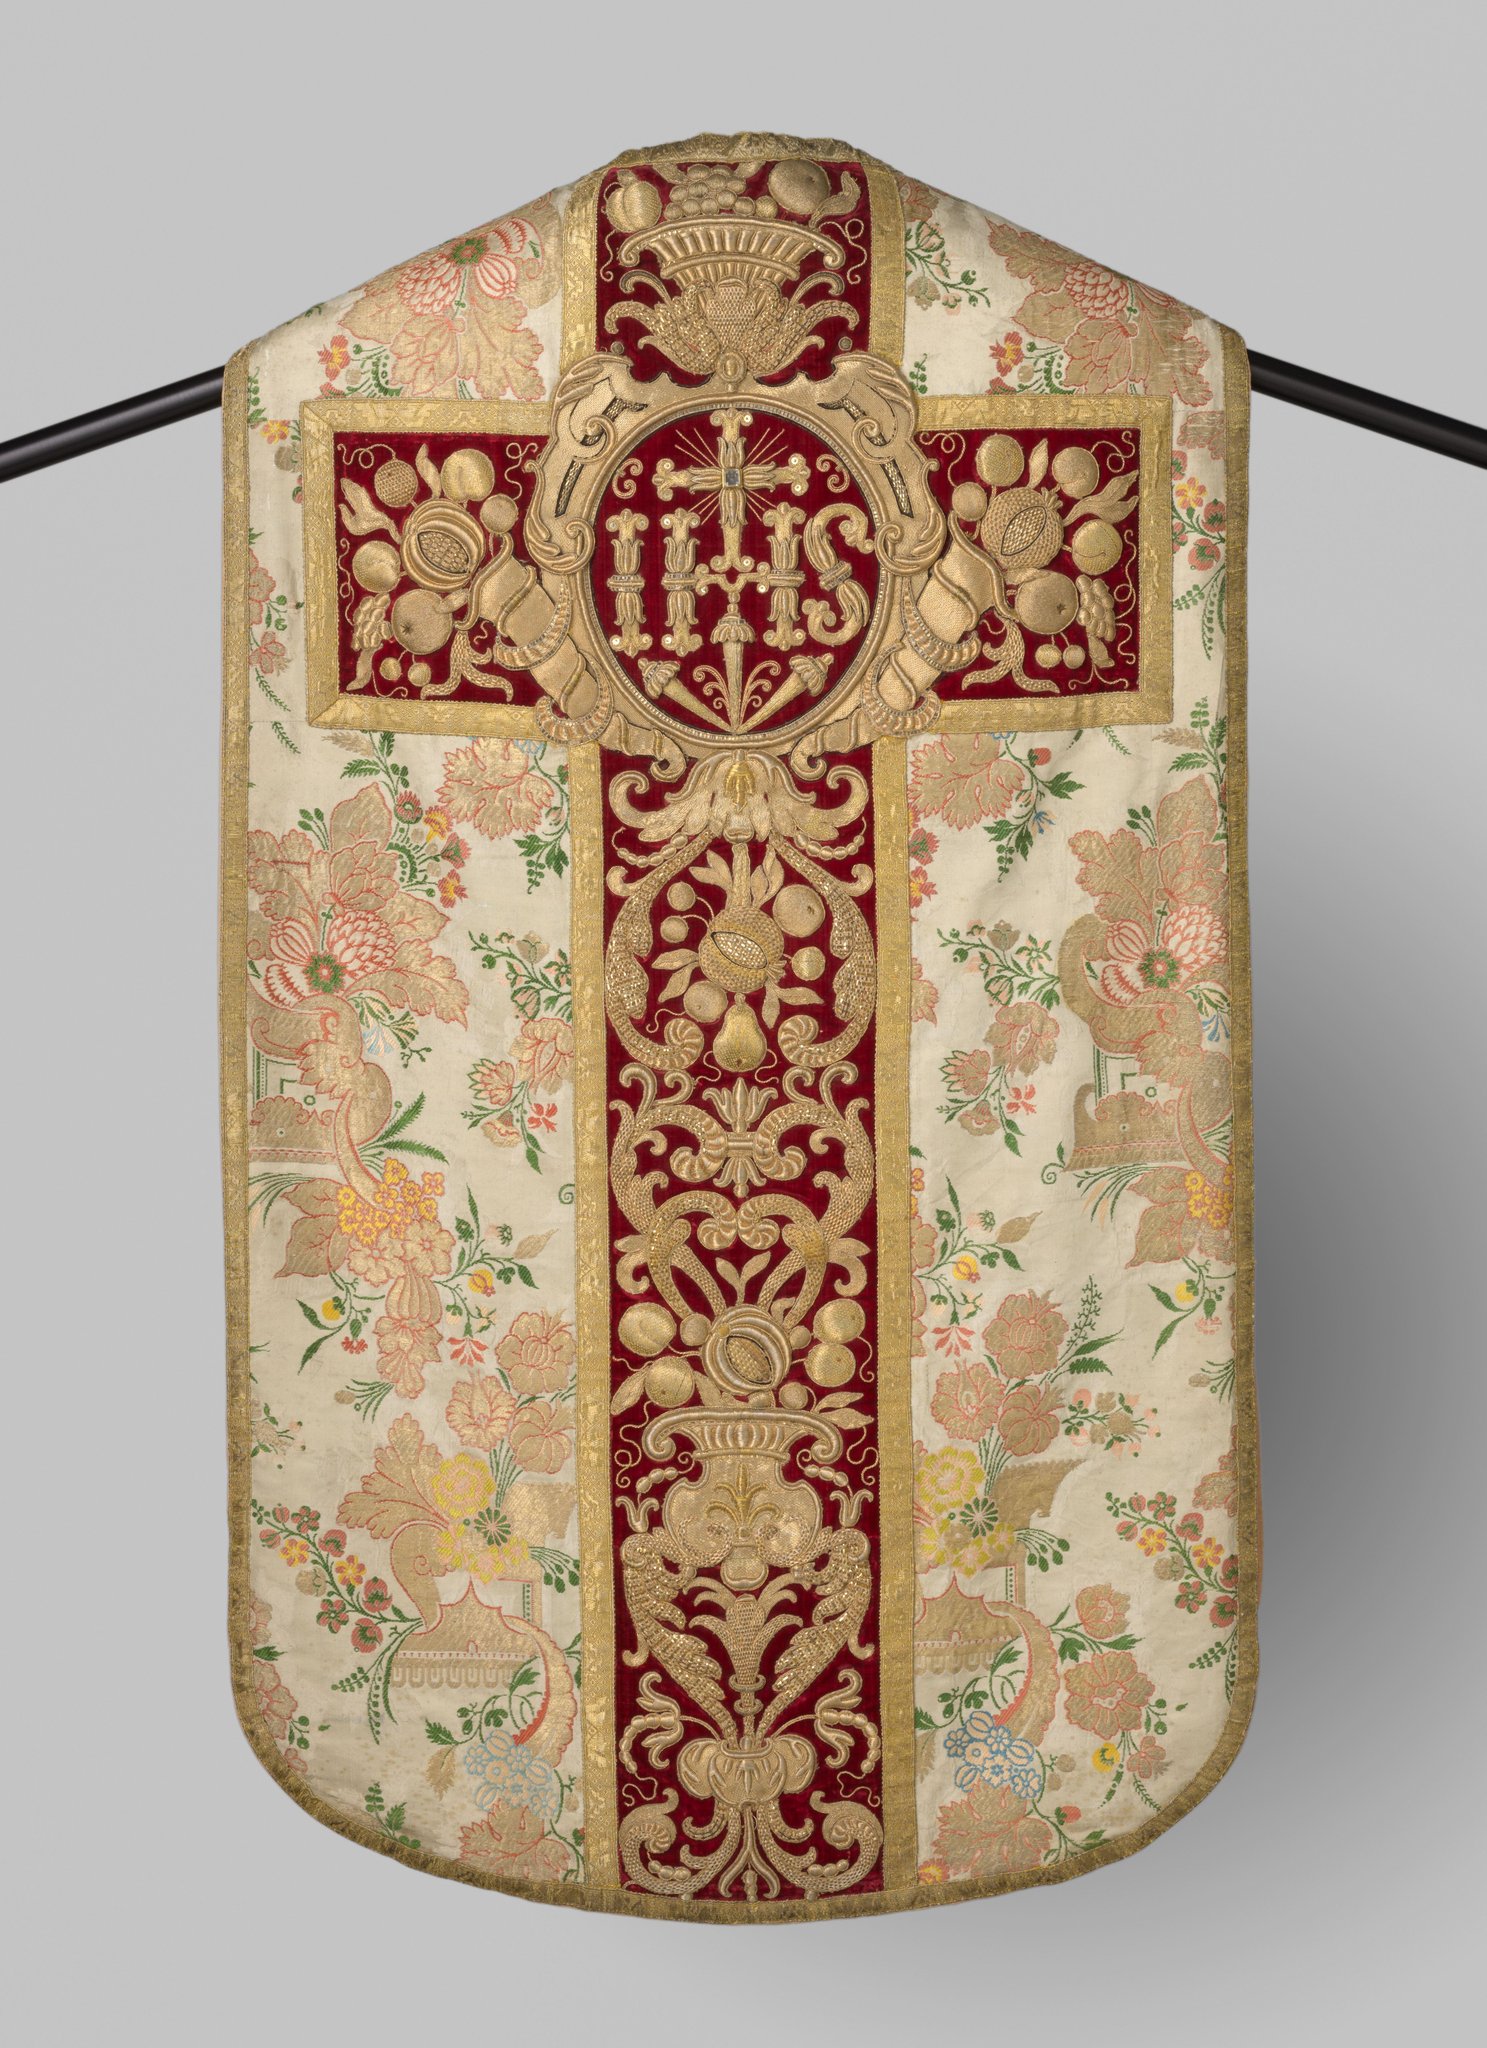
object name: chasuble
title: Kazuifel van goudbrokaat en borduurwerk in gouddraad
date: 1700-1725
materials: gold thread, velvet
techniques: brocade, embroidered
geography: france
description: Kazuifel met borduurwerk. De kazuifel heeft een vioolvorm met op de voorzijde een kolom en op de rug een kruisvormig aurifries. Op de kolom zijn symmetrische ranken geborduurd die een vaas dragen vanwaar dubbele voluten opgaan. Het rugkruis heeft een rond middencartouche met het IHS-teken, een kruis en drie nagels. De kazuifel hoort bij negen kerkelijke weefsels met borduurwerk met invnrs. BK-1972-1-A t/m BK-1972-1-I en een niet bijbehorende beurs met invnr. BK-1972-1-J.